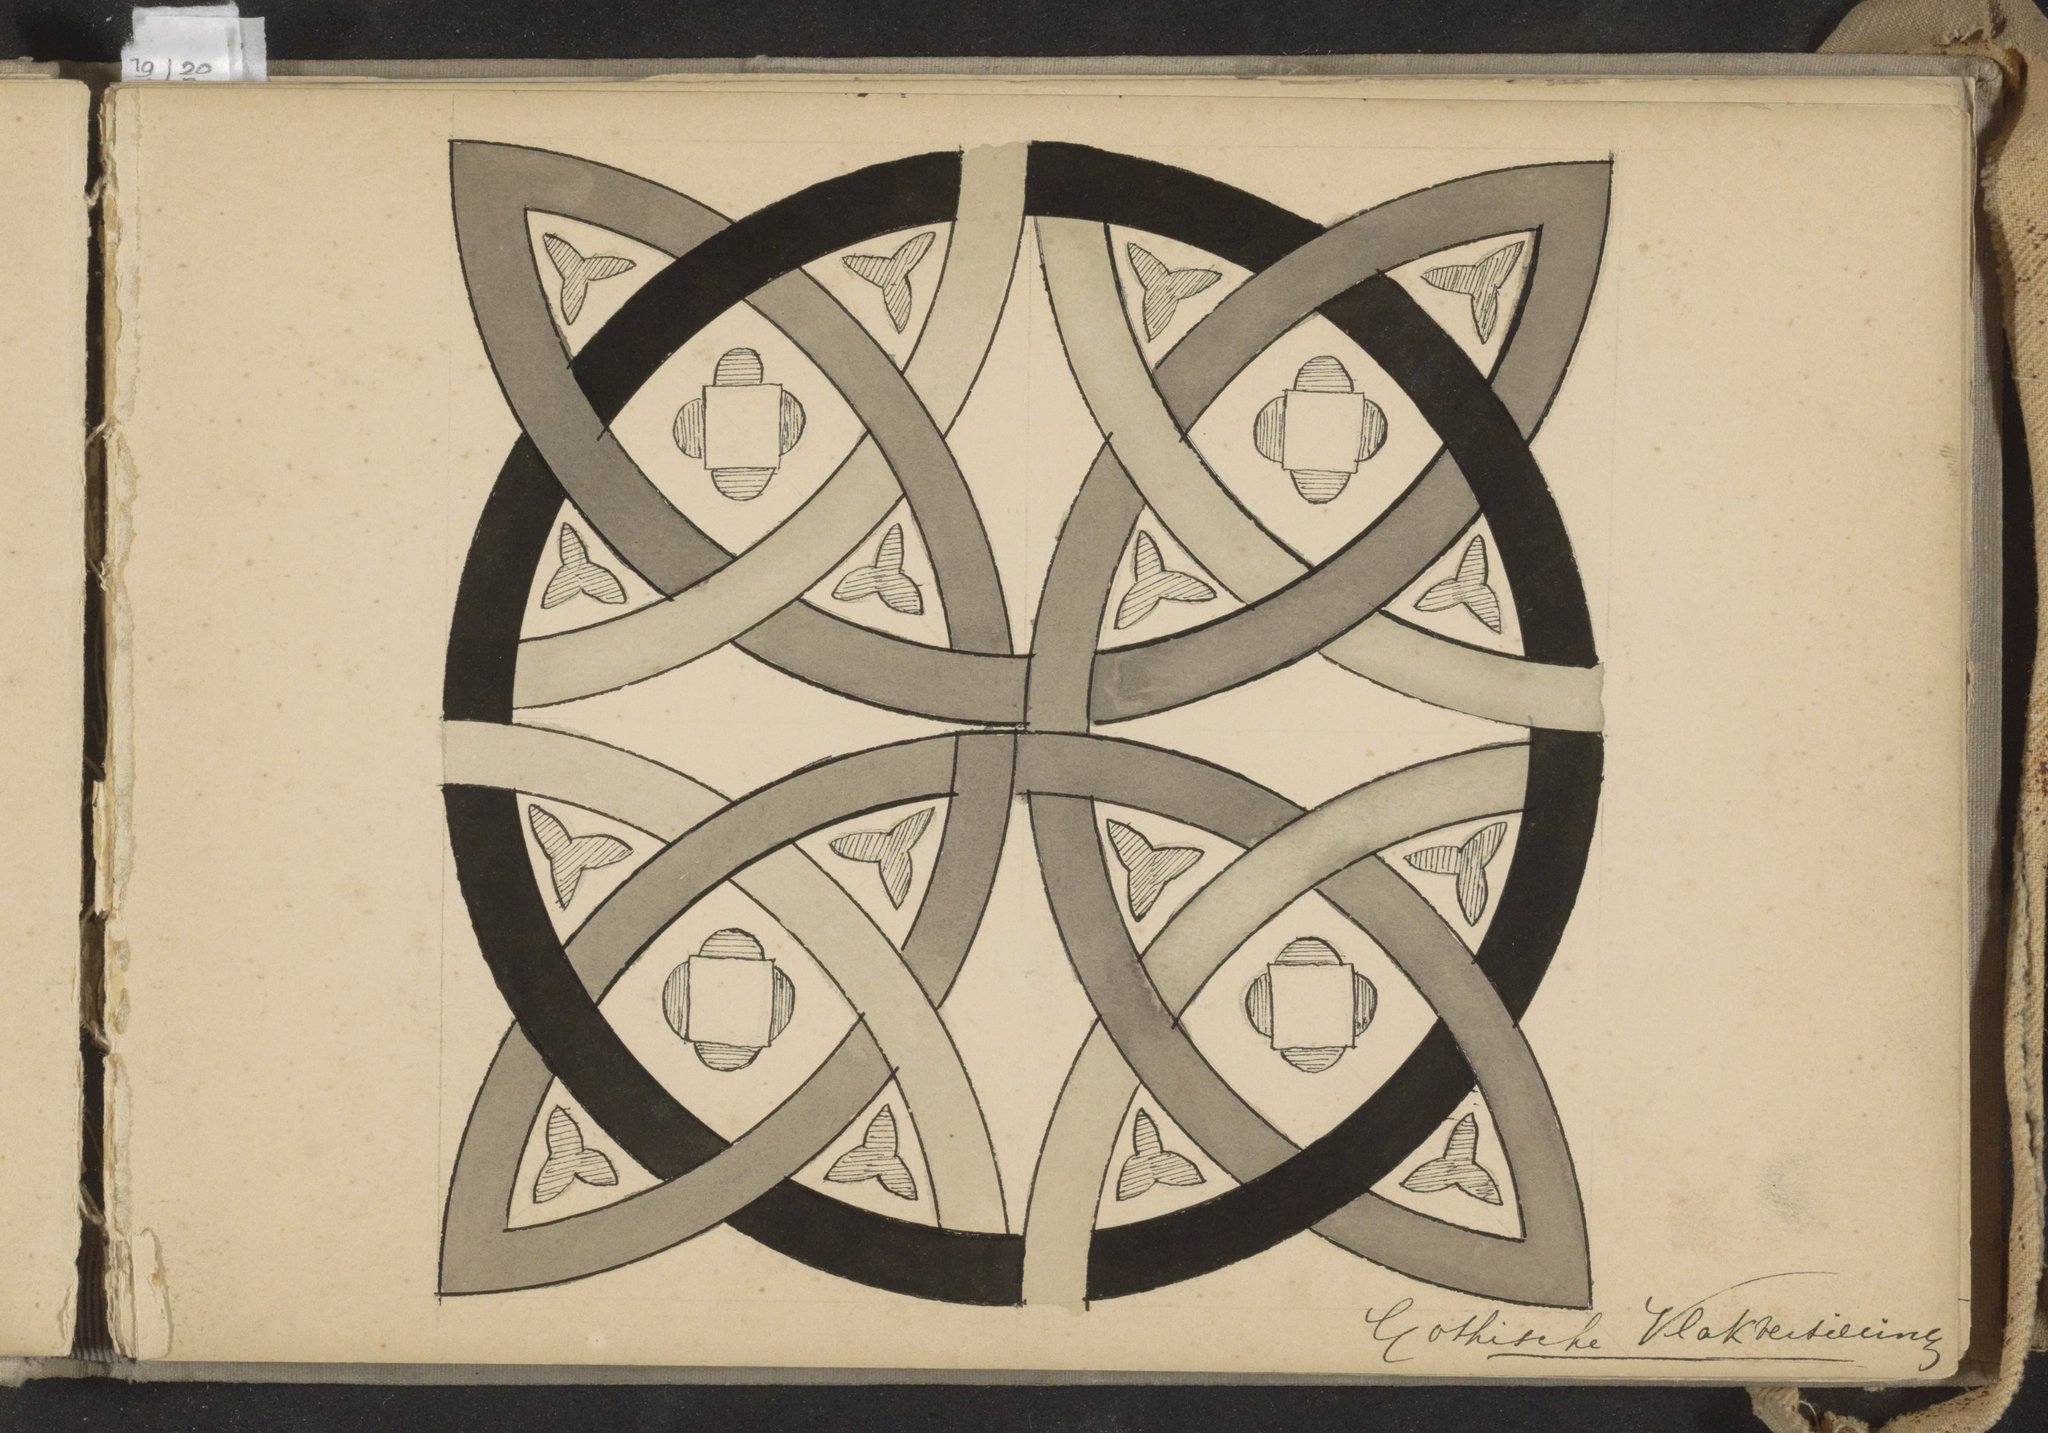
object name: sketchbook leaf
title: Gotische vlakversiering met vlechtwerk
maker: johanna van de kamer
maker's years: 1873-1922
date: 1890-1922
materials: ink, paper, pencil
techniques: brush, pen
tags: interlace ~ ornament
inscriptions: annotation: ‘Gothische vlakverdeling’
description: Blad 16 recto uit een schetsboek met 43 bladen.